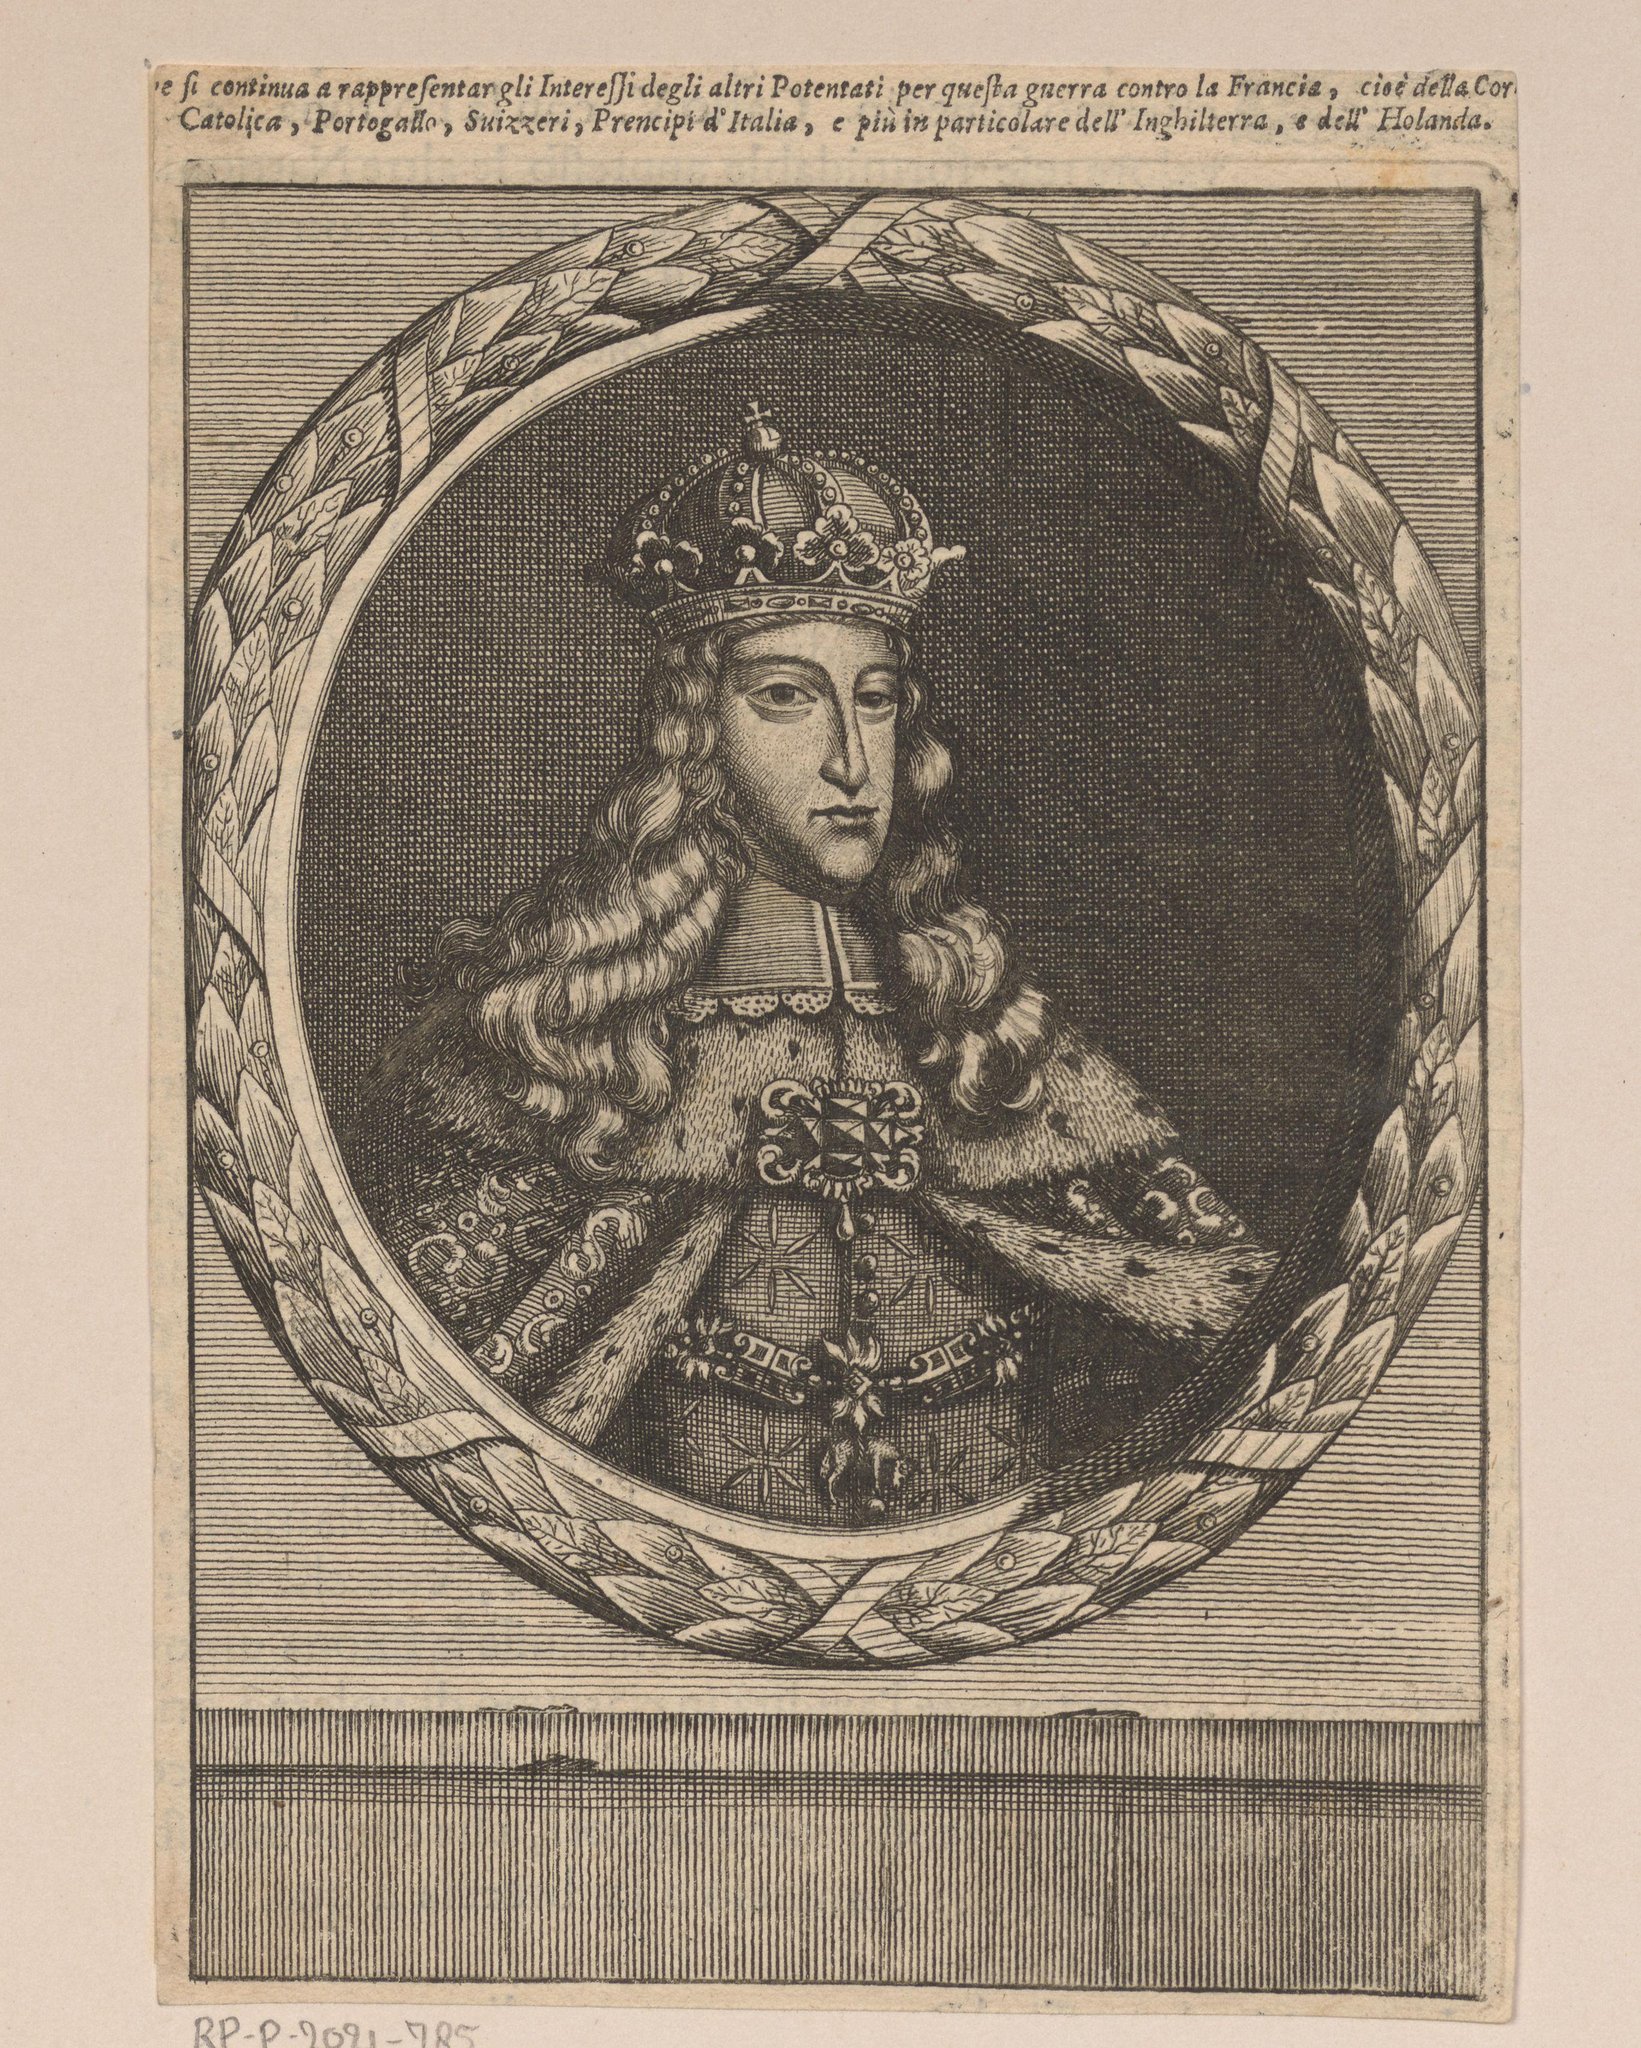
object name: book illustration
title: Portret van Karel II, koning van Spanje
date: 1691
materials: paper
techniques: engraving, letterpress printing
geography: amsterdam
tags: karel ii (koning van spanje), crown (symbol of sovereignty), historical persons, knighthood order of the golden fleece, king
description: Prent uit: Leti, Gregorio. Teatro Gallico (...). 7 dln. Amsterdam: Willem de Jonge, 1691, dl. 3, p. 173.